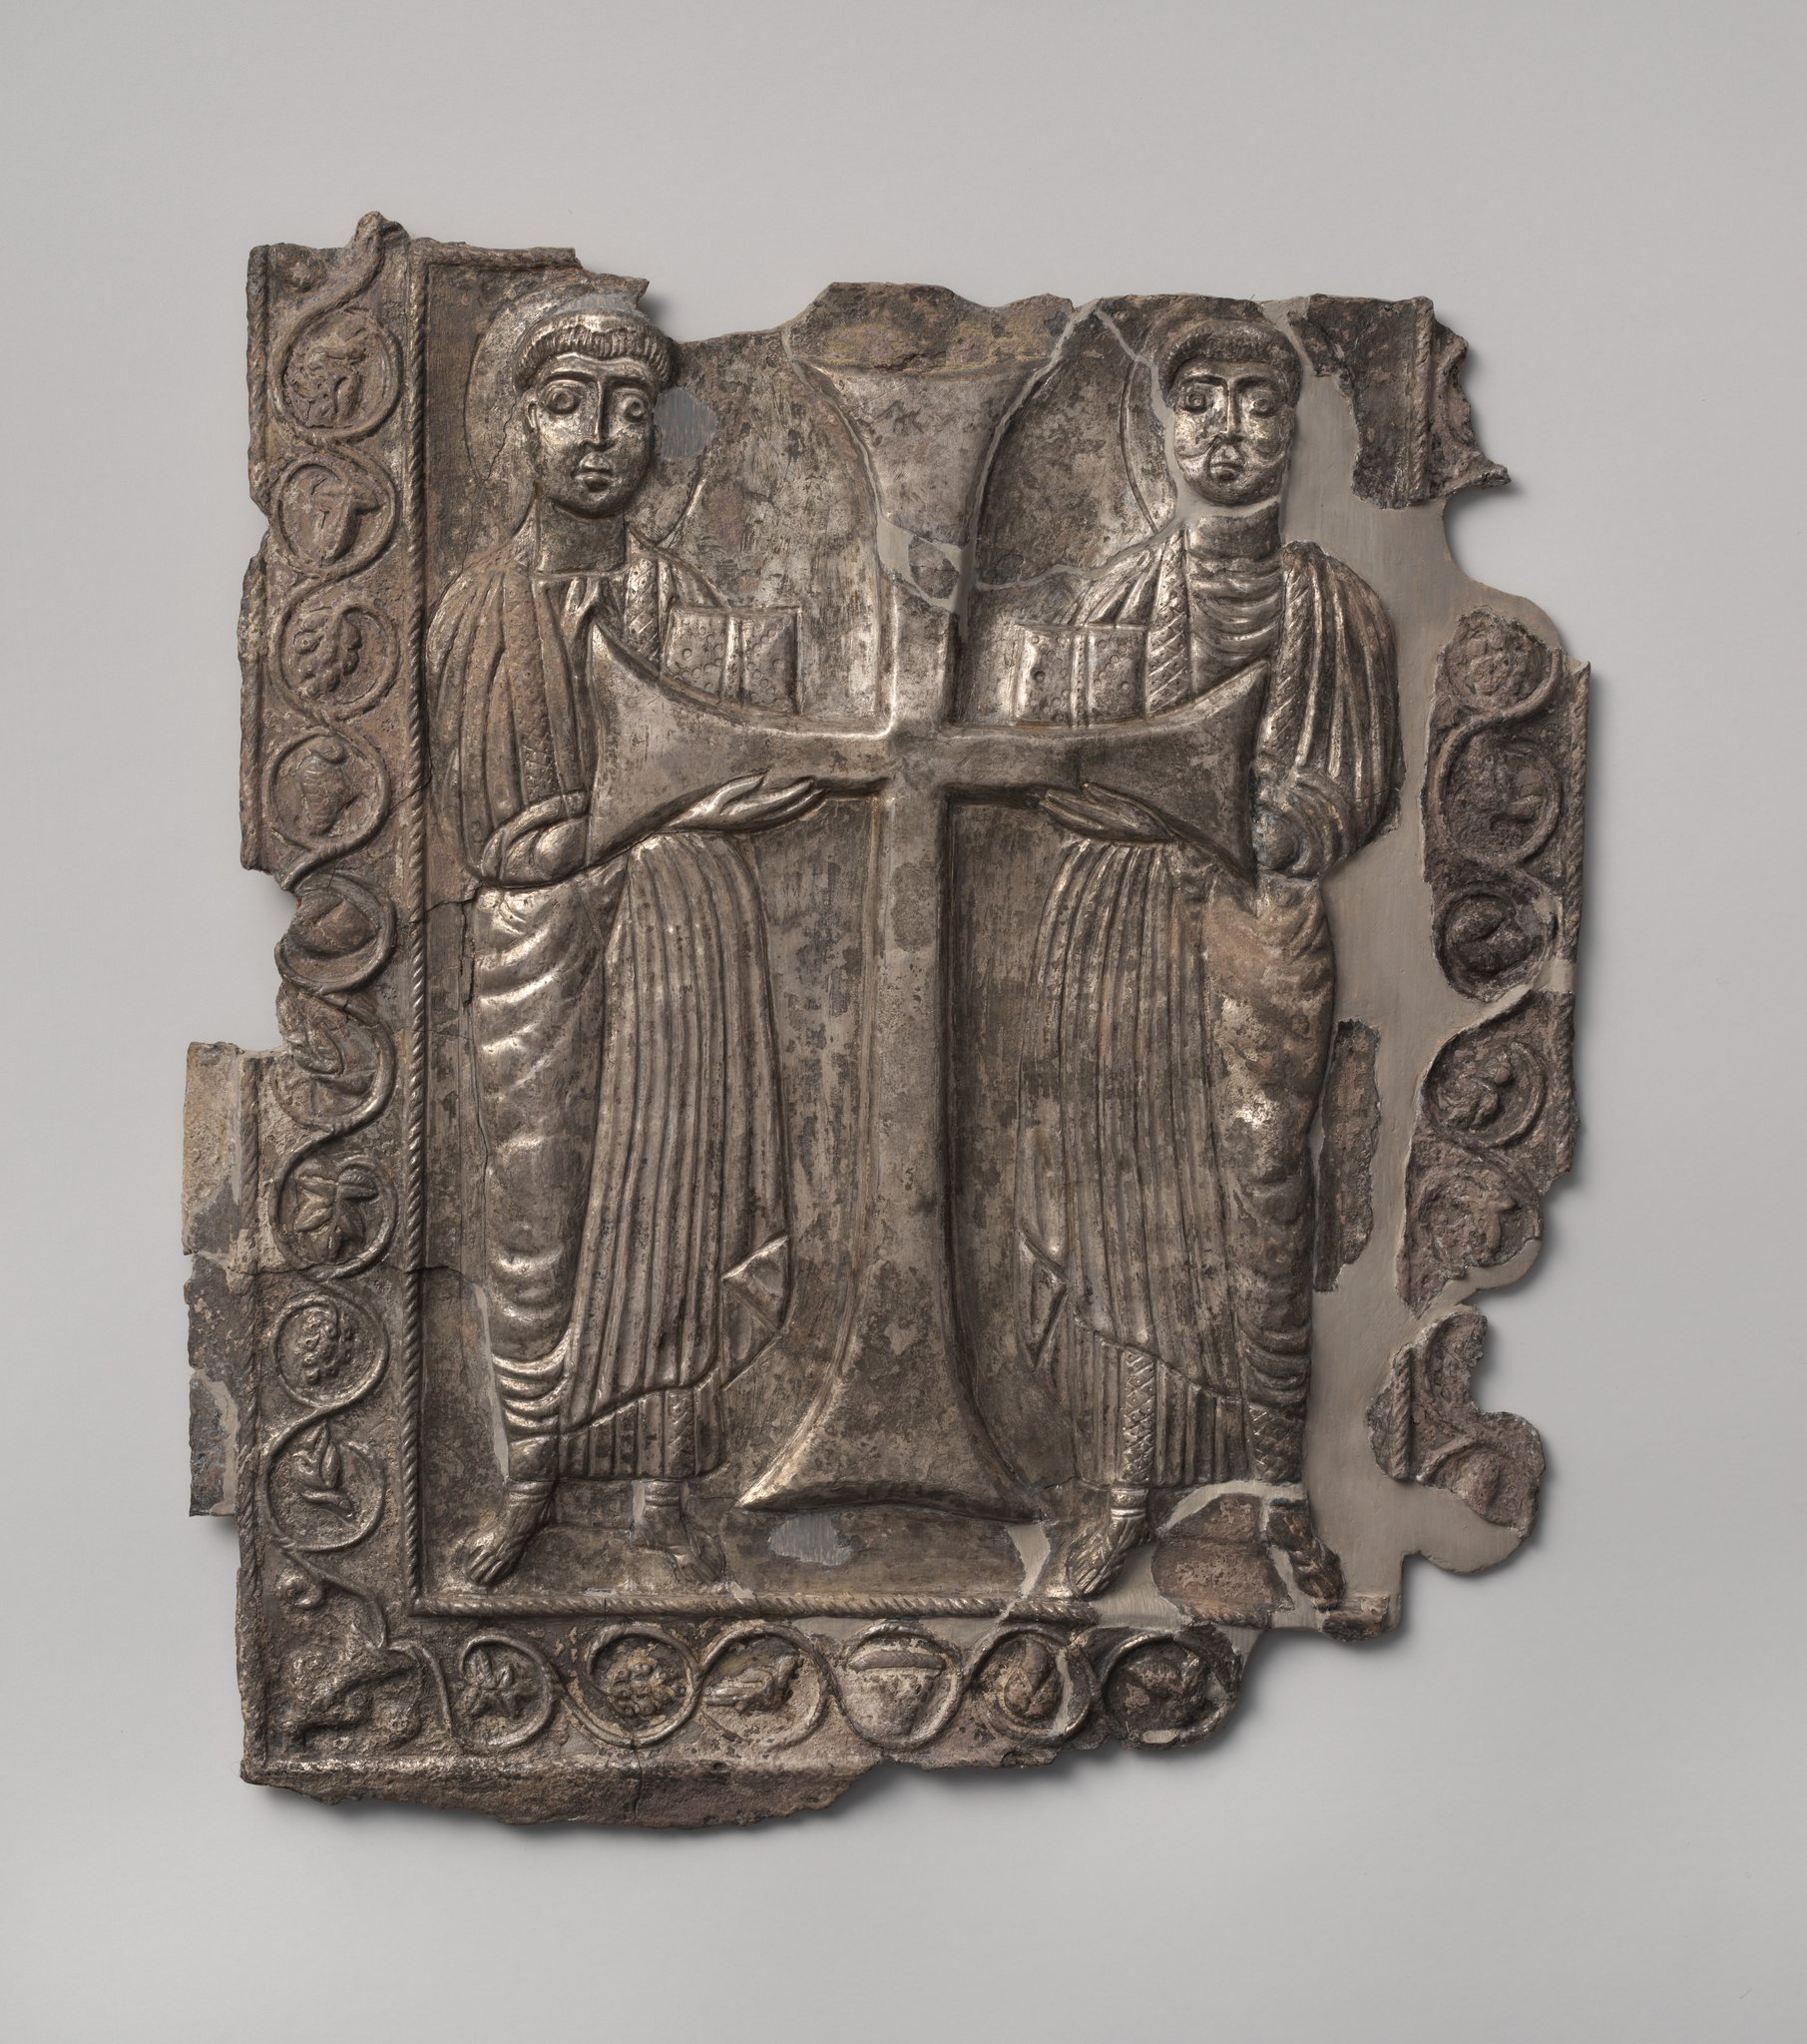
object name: plaque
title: Plaque with Two Saints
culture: byzantine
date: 501-600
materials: gilt, silver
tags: cross